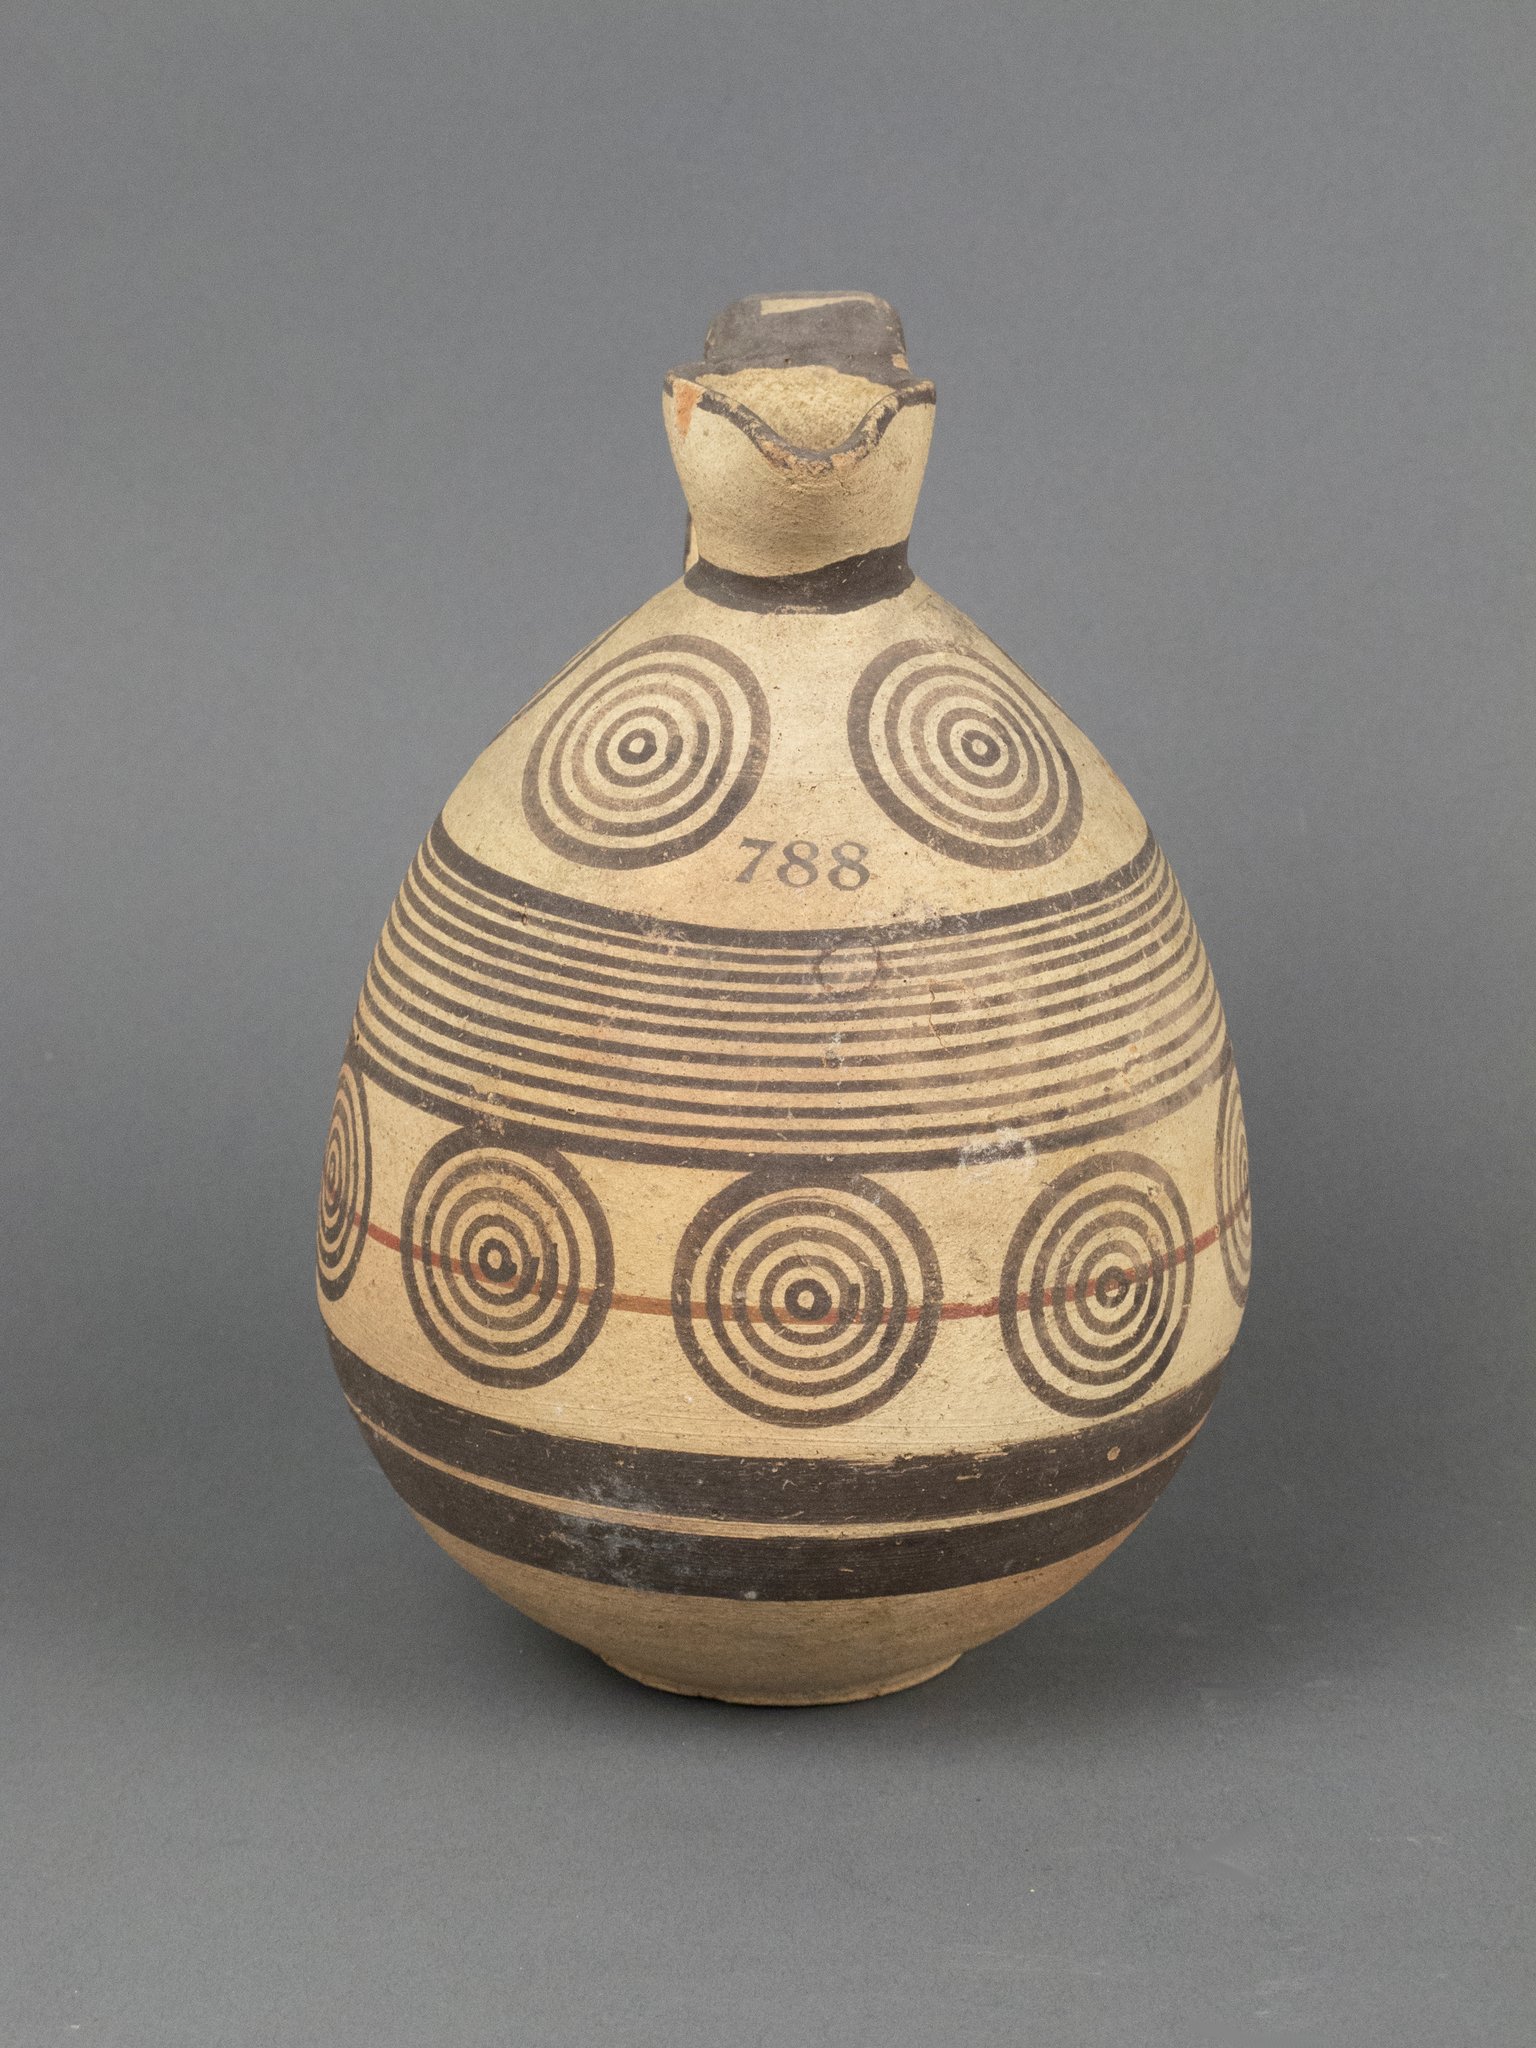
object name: jug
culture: cypriot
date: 600-480 BCE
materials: terracotta